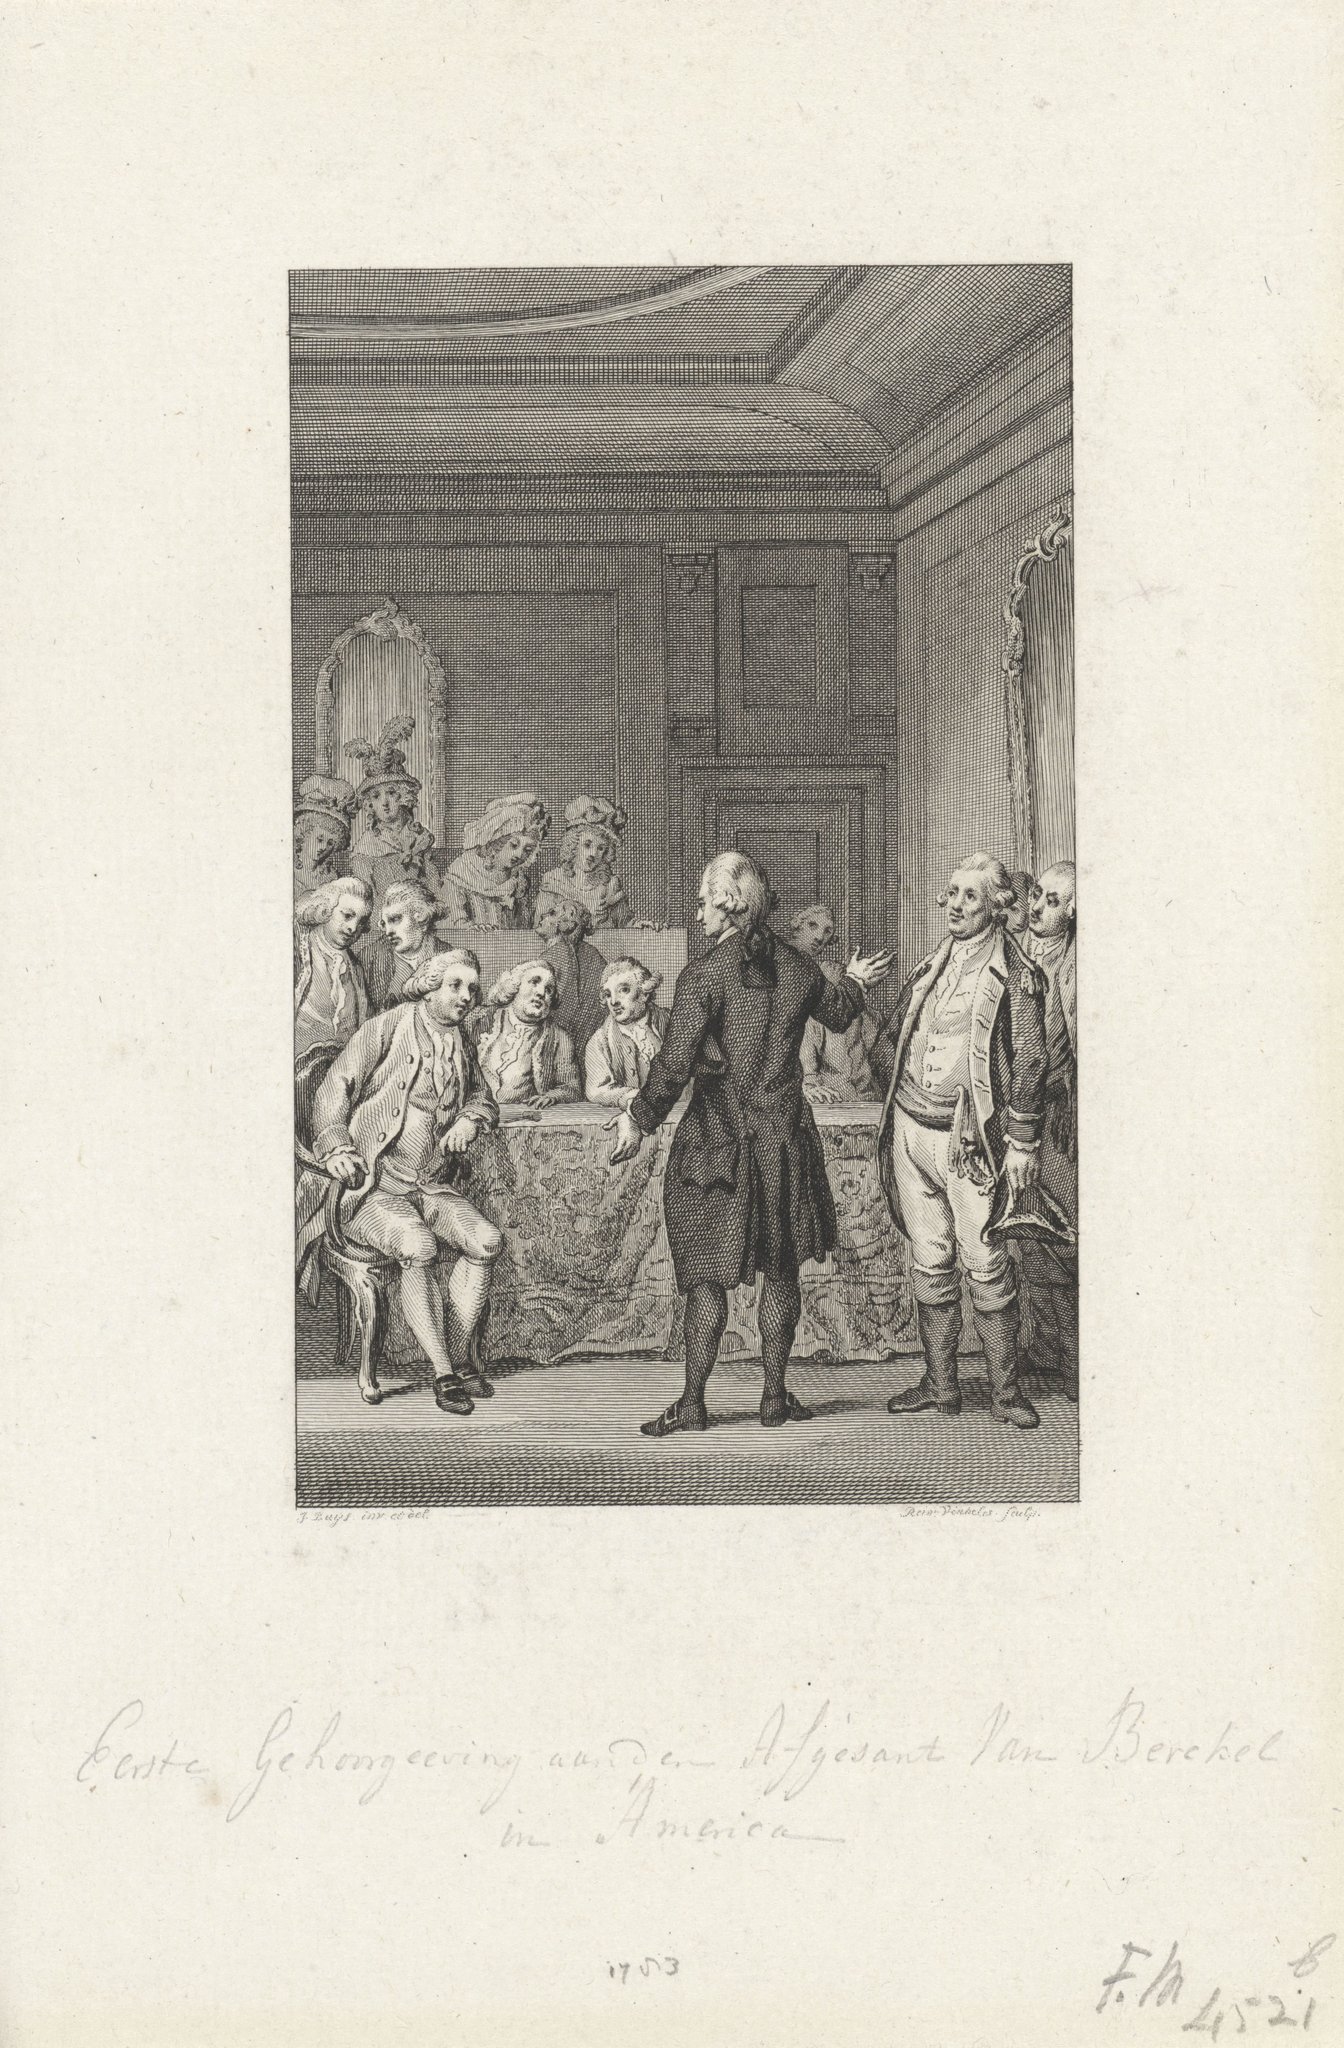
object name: print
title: Ontvangst van de eerste Nederlandse gezant in de Amerikaanse senaat, 1783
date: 1788-1790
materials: paper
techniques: engraving, etching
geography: amsterdam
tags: rotterdam, united states of america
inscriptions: collector's mark: Lugt 240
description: Gebruikt als illustratie in: P.A. Loosjes. Vaderlandsche historie, vervattende de geschiedenissen, der Vereenigde Nederlanden (...). Ten onmiddelyken vervolge van Wagenaar's Vaderlandsche historie. Amsterdam: Johannes Allart, dl. 5, 1790.